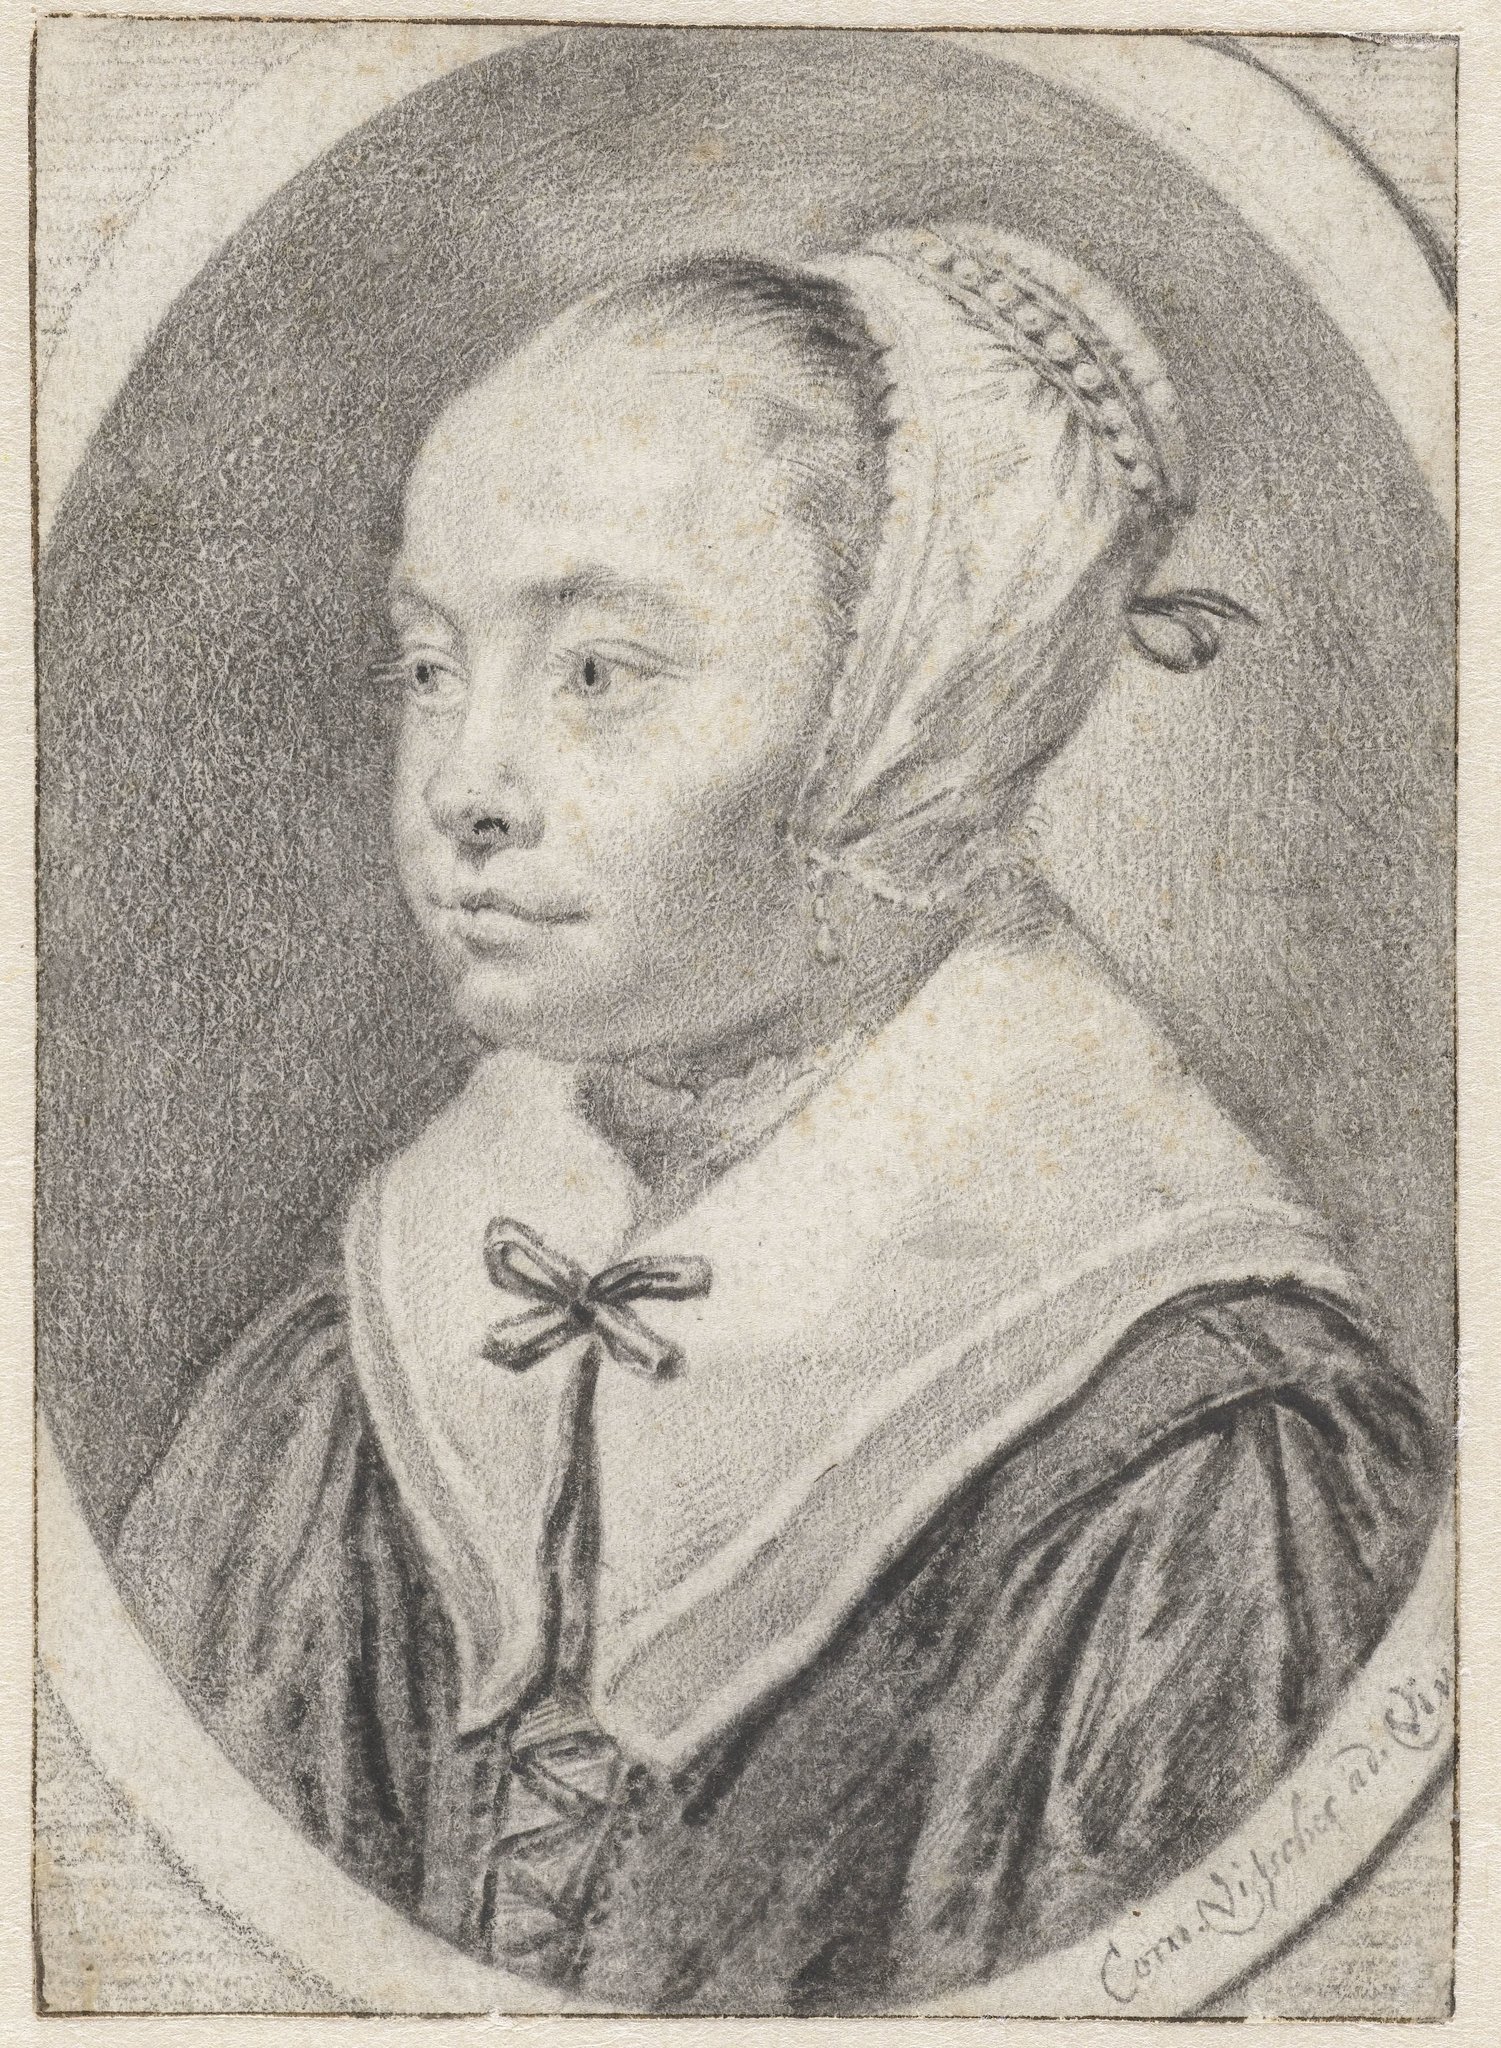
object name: drawing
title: Portrait of a Girl with a Cap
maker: cornelis visscher (ii)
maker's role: draughtsman, painter, print maker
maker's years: 1628-1658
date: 1645-1650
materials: chalk, paper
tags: girl (child between toddler and youth)